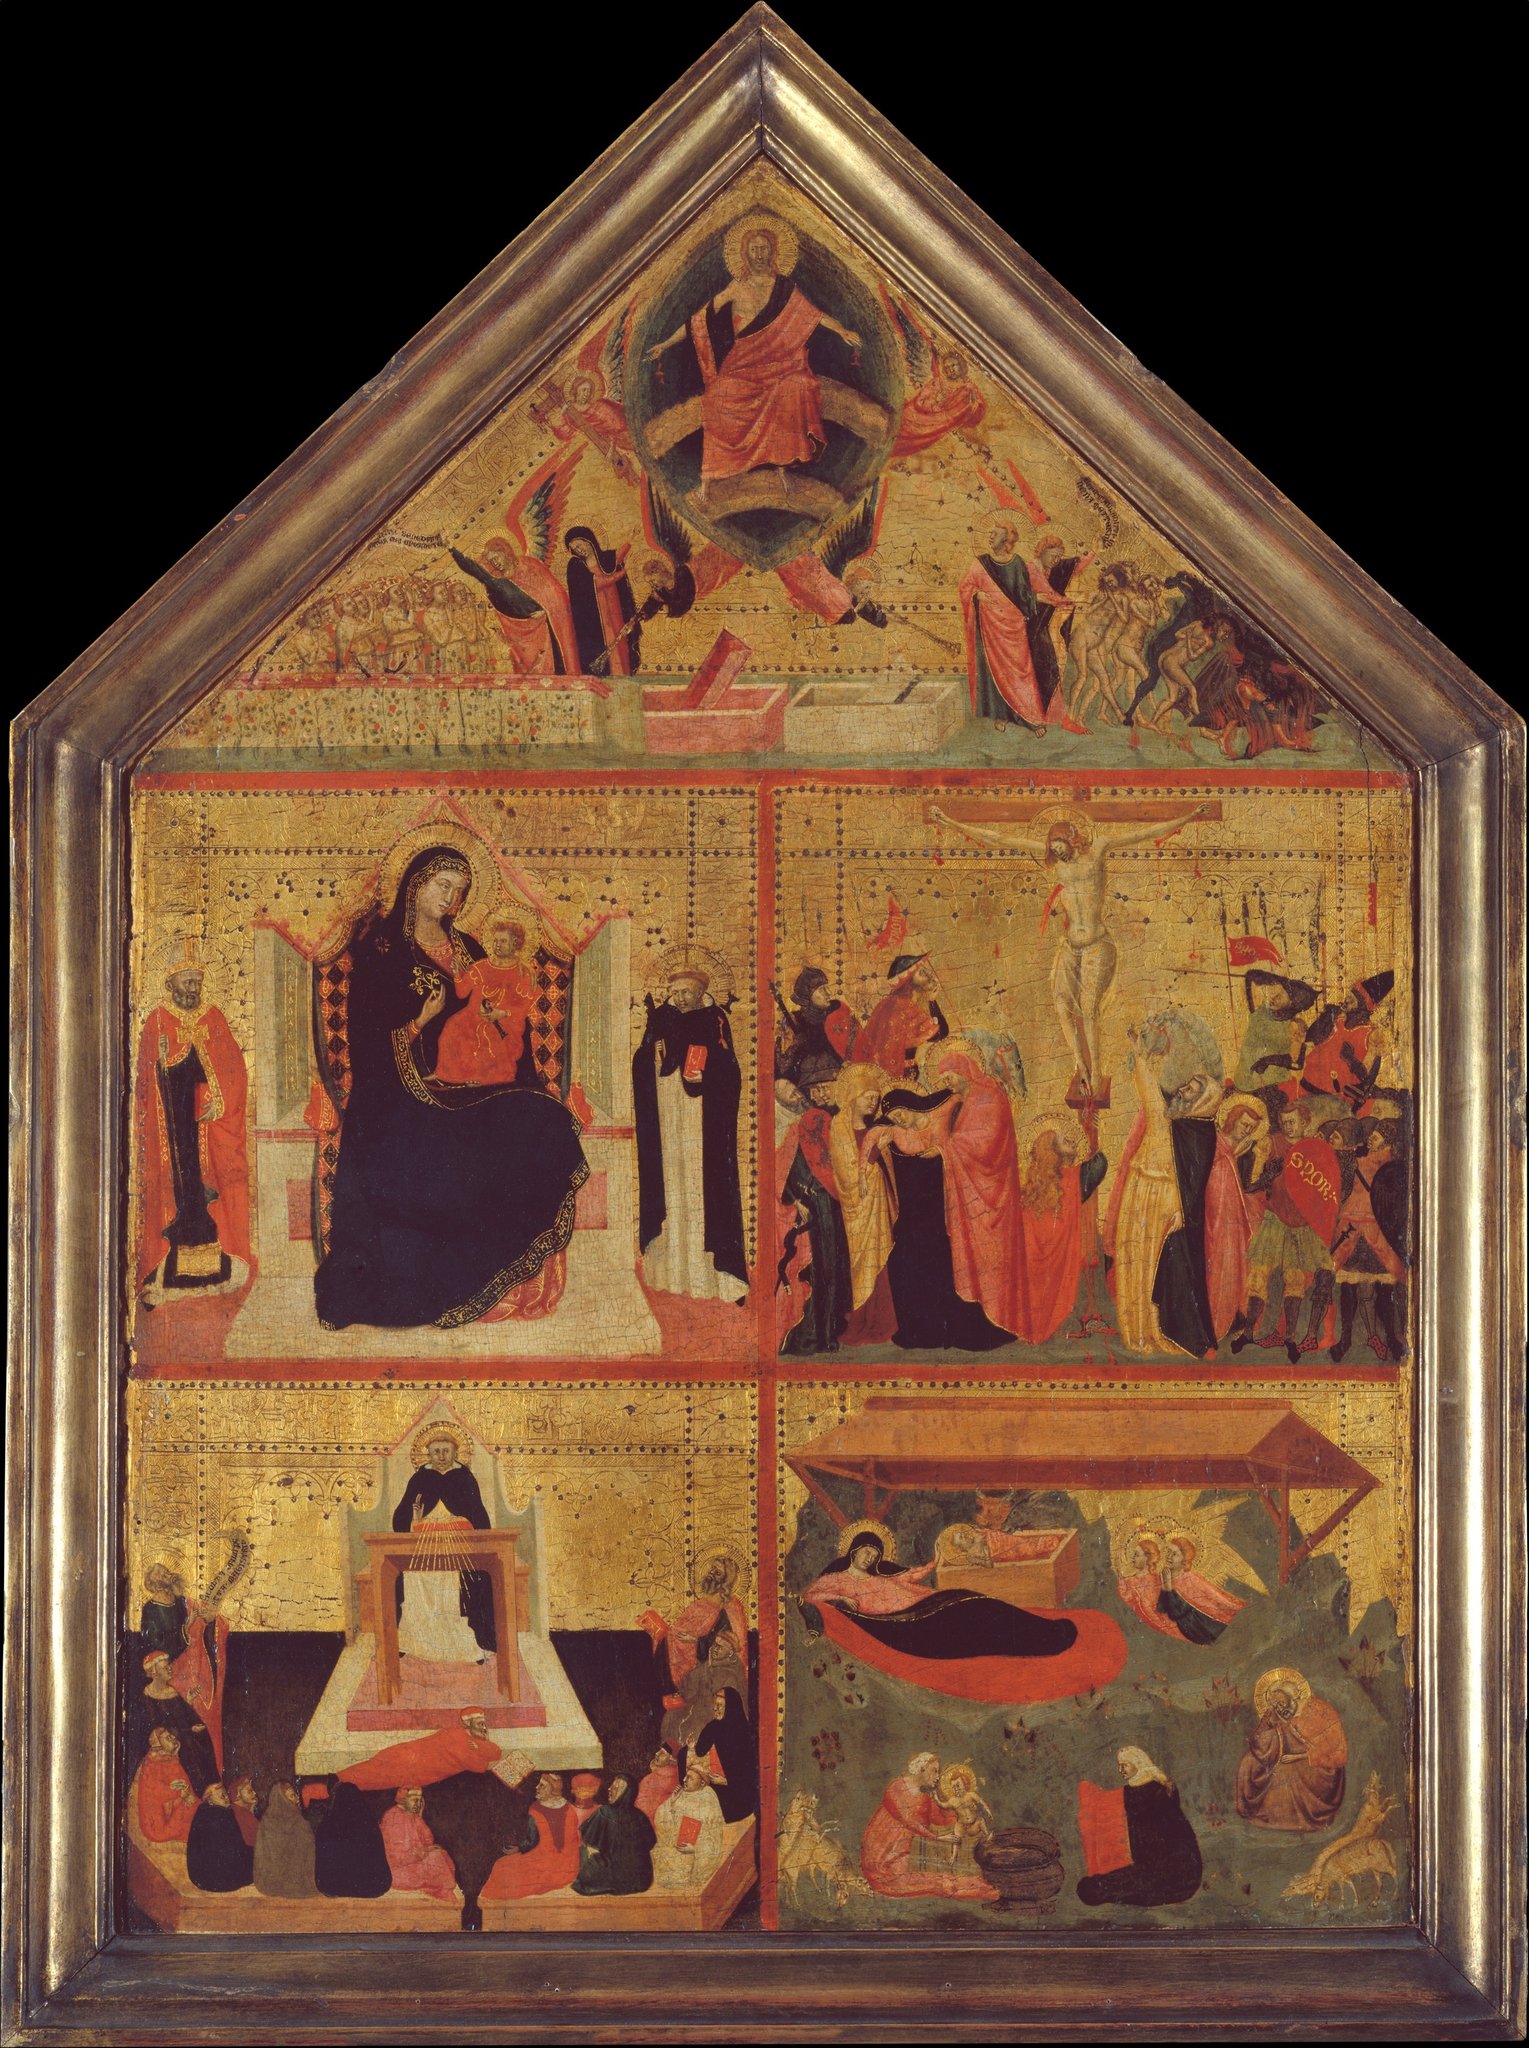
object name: painting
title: The Last Judgment; The Virgin and Child with a Bishop-Saint and Saint Peter Martyr; The Crucifixion; The Glorification of Saint Thomas Aquinas; The Nativity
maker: master of the dominican effigies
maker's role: artist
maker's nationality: italian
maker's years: 1325-1355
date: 1325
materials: gold leaf, paint, wood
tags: madonna and child,saint peter,crucifixion,last judgement,nativity